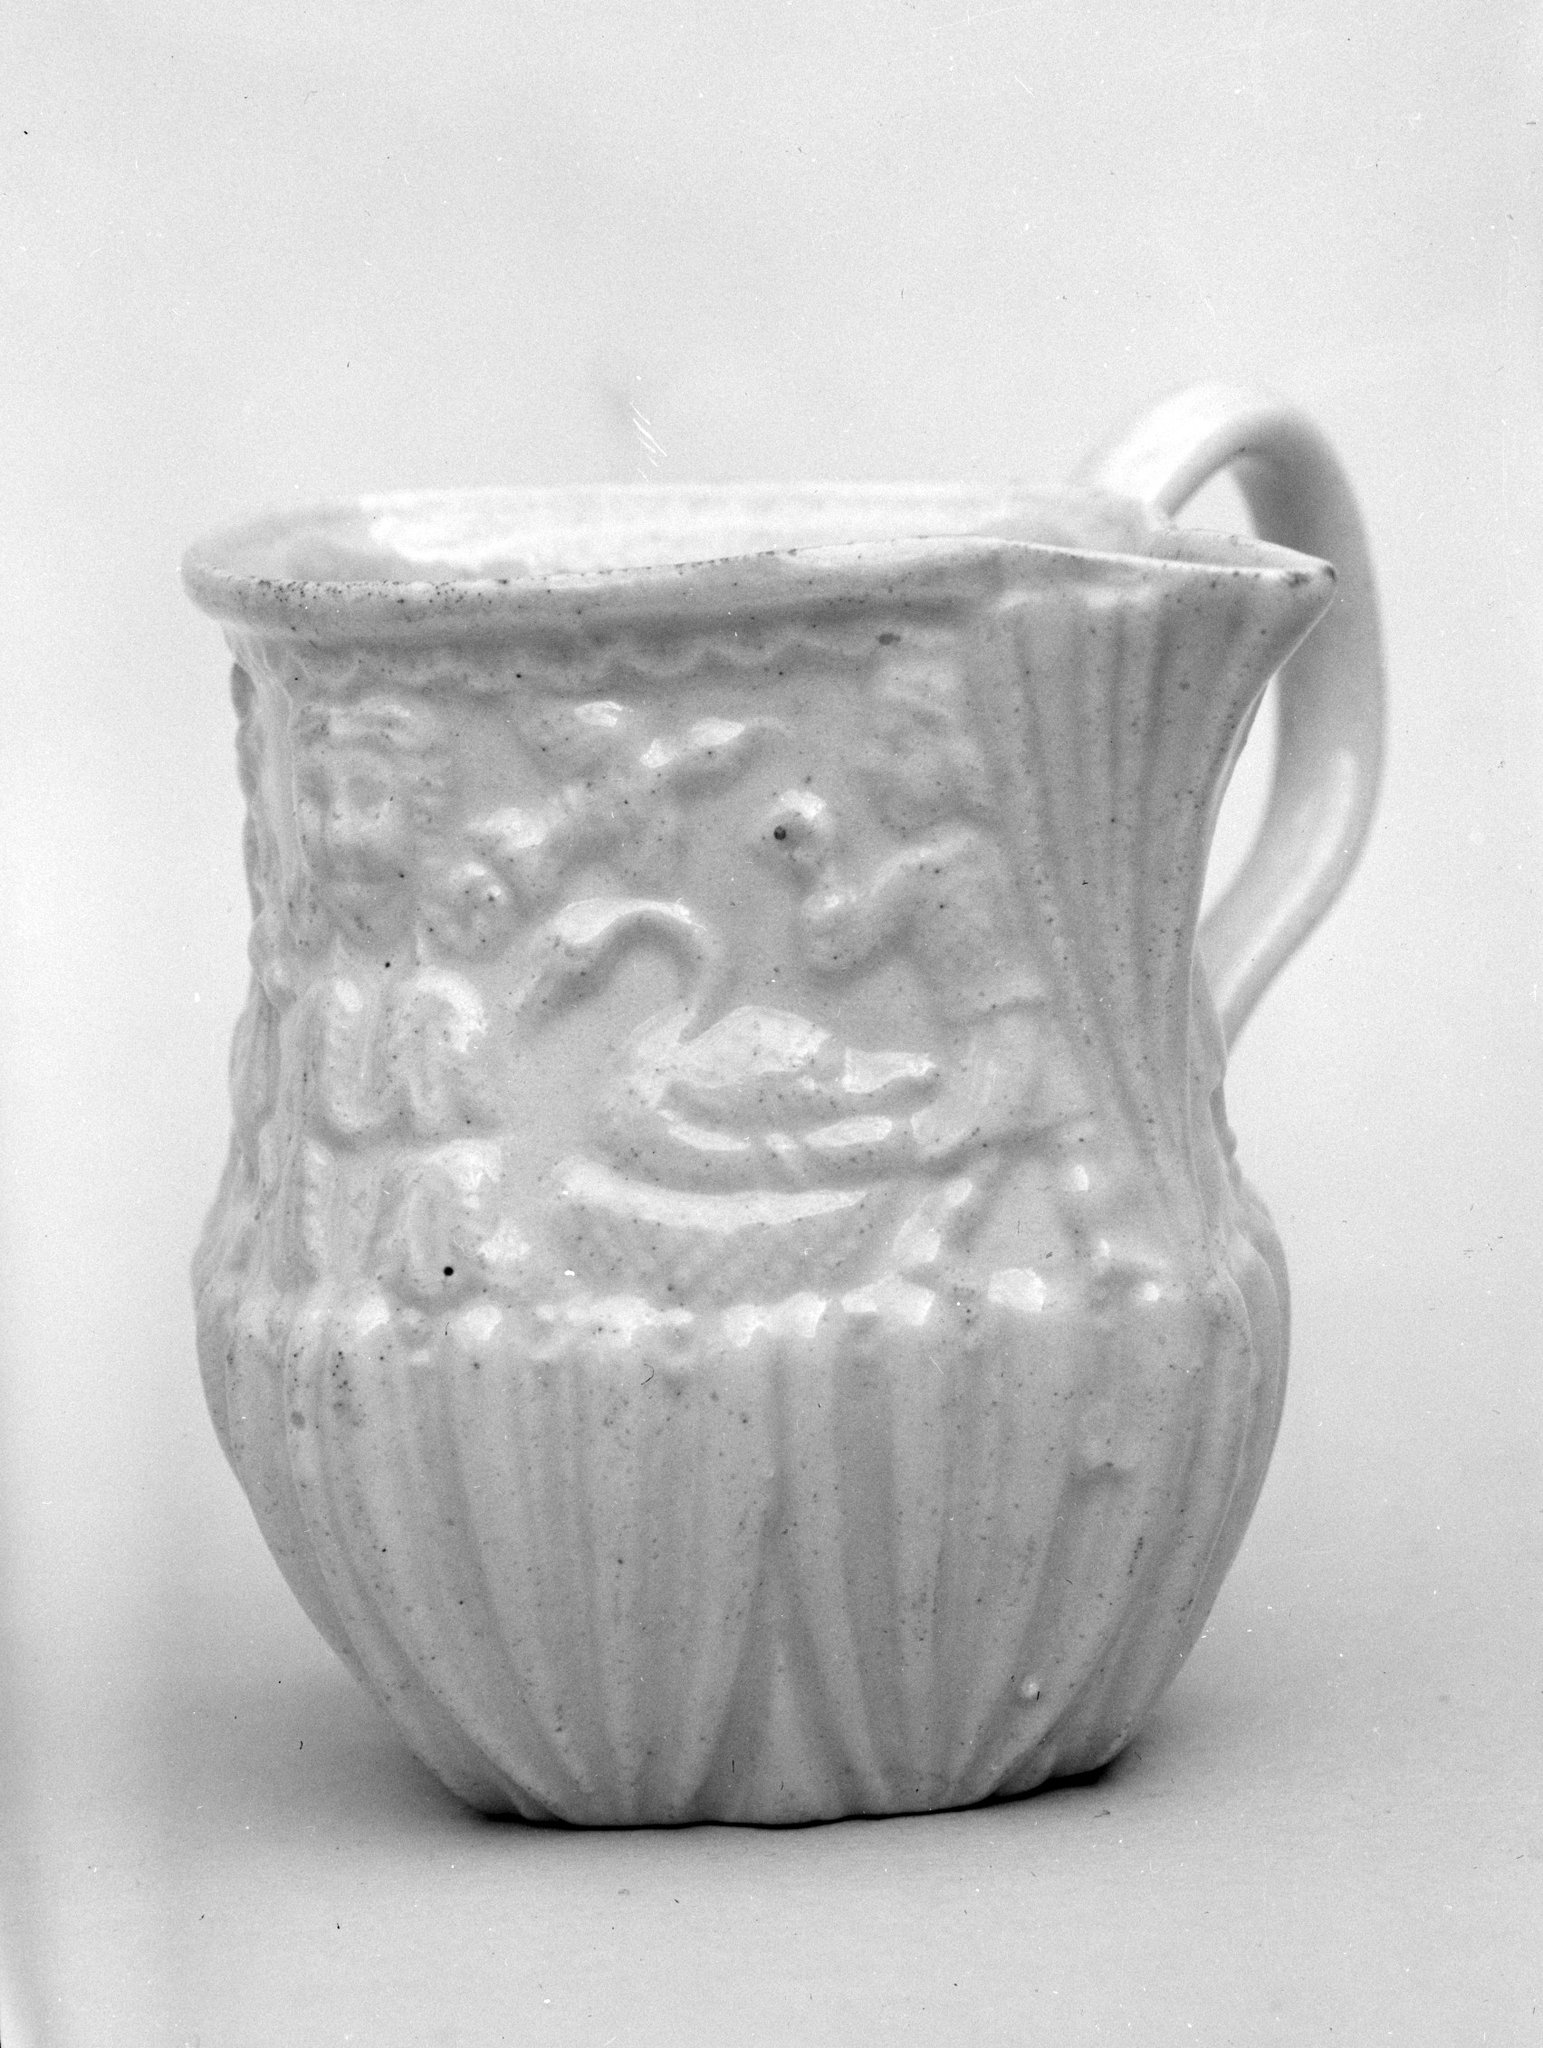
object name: cream pitcher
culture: british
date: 1740-1750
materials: stoneware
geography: england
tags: men,swans